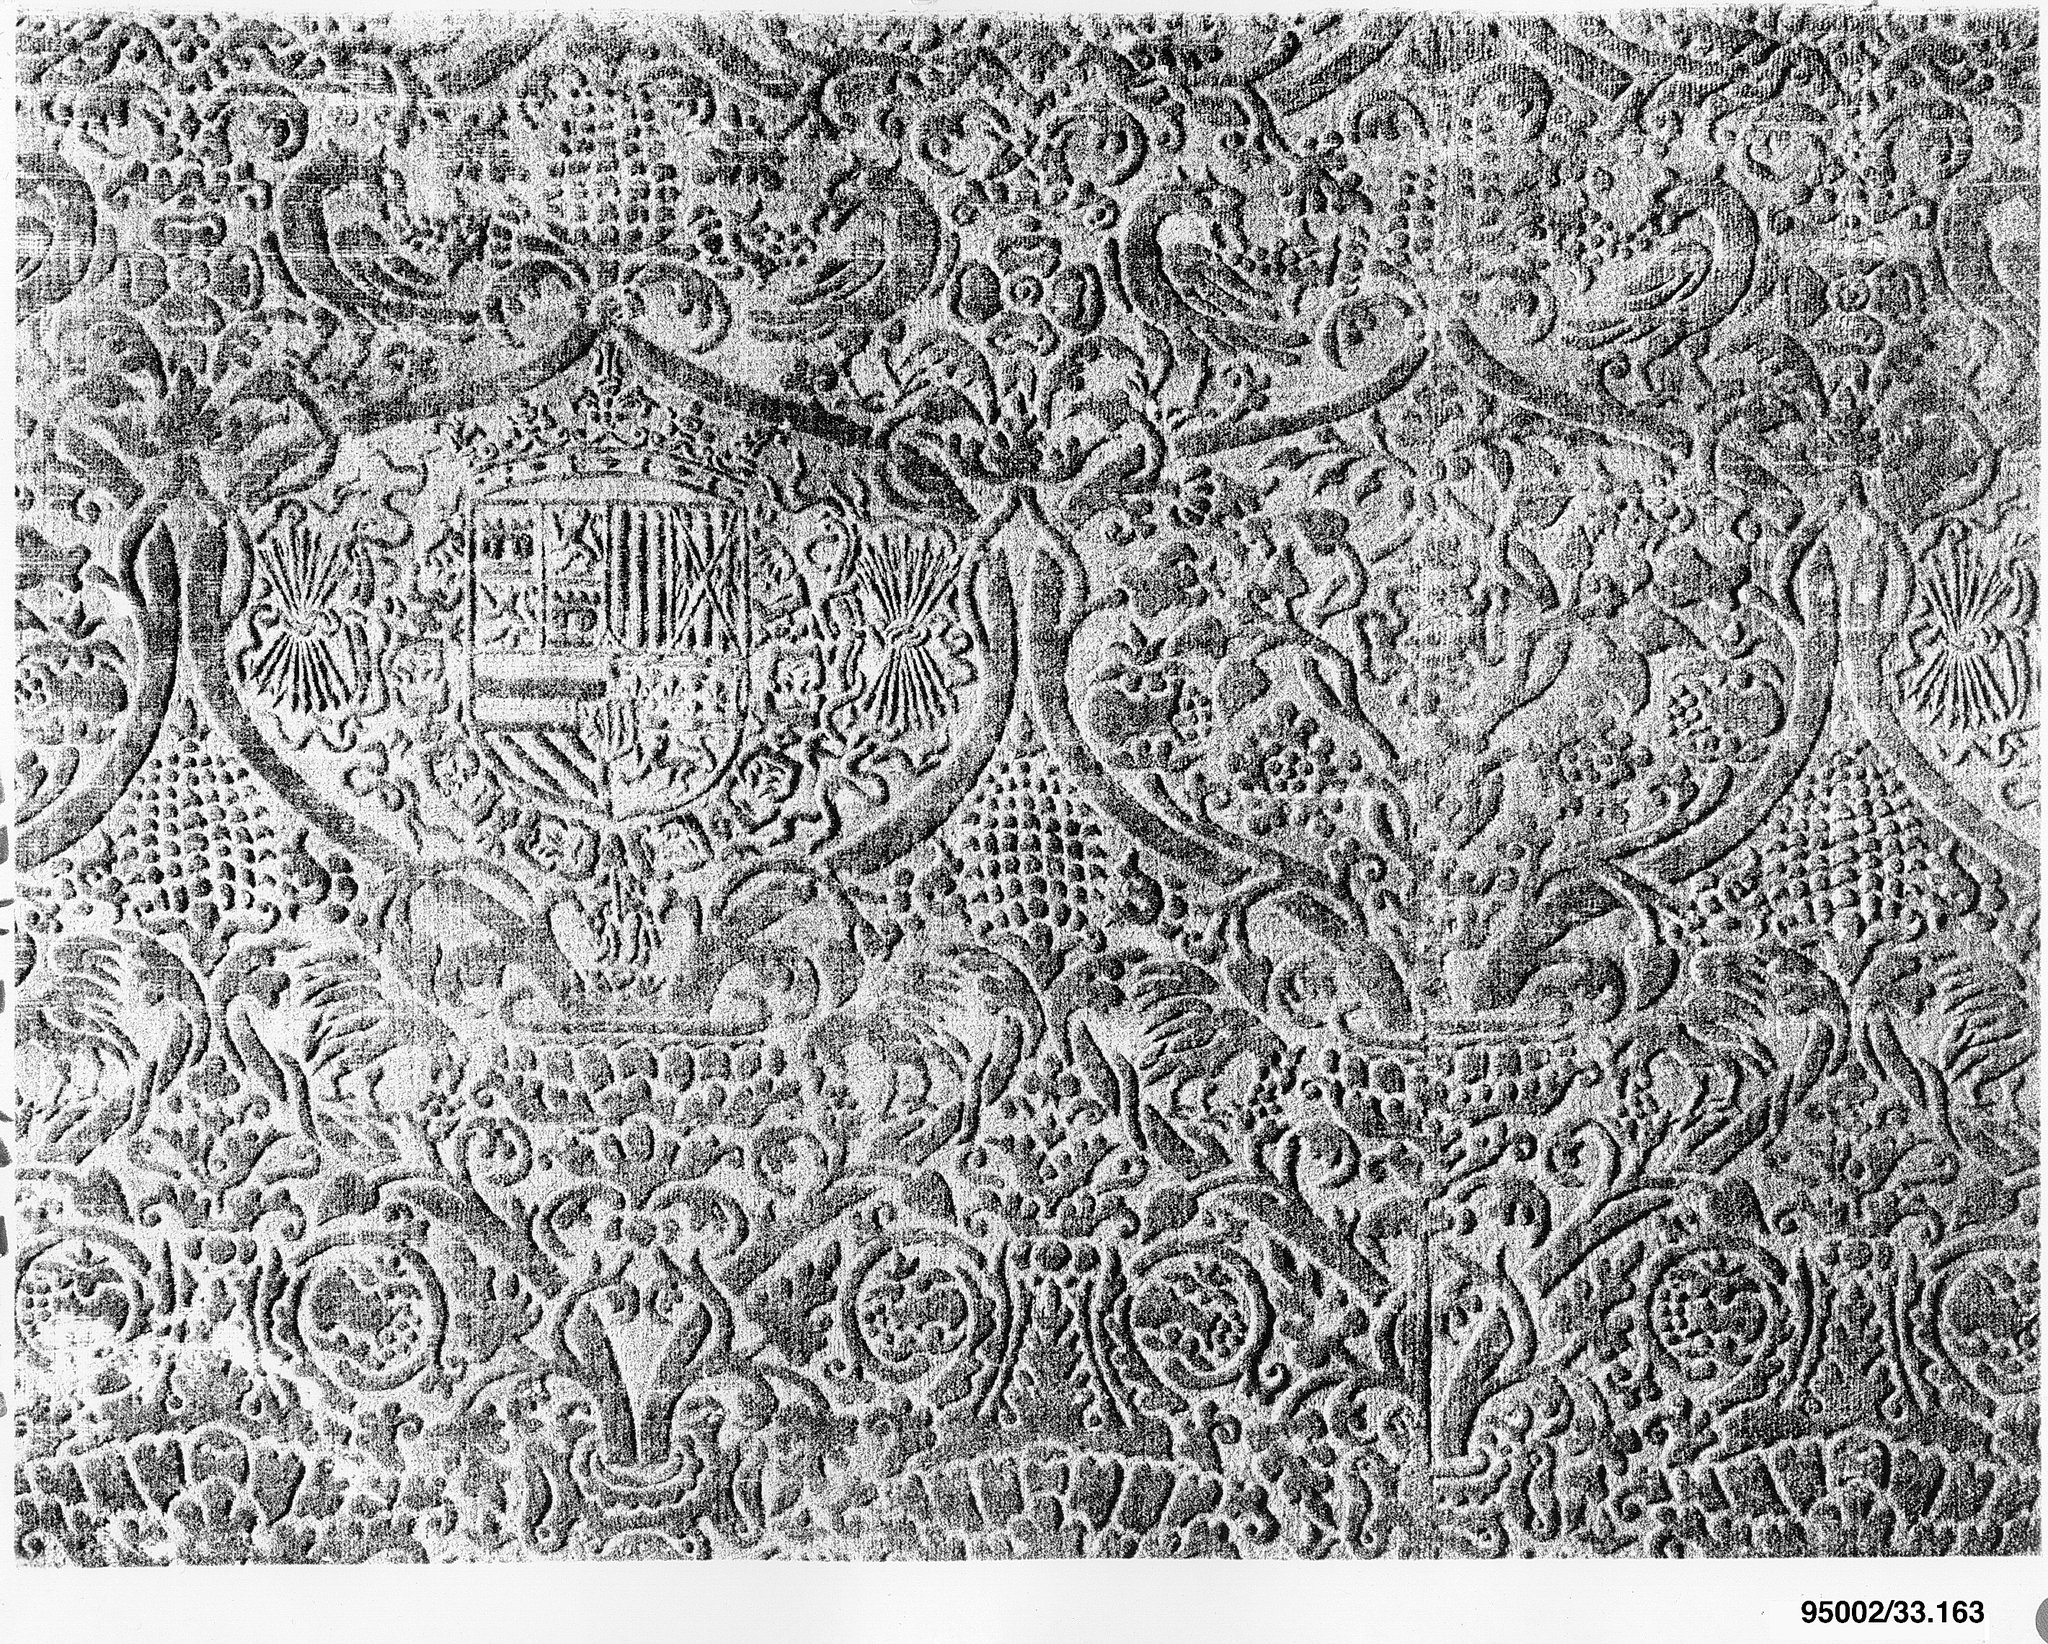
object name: border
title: Velvet with the arms of Philip II of Spain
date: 1501-1600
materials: wool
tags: birds,coat of arms